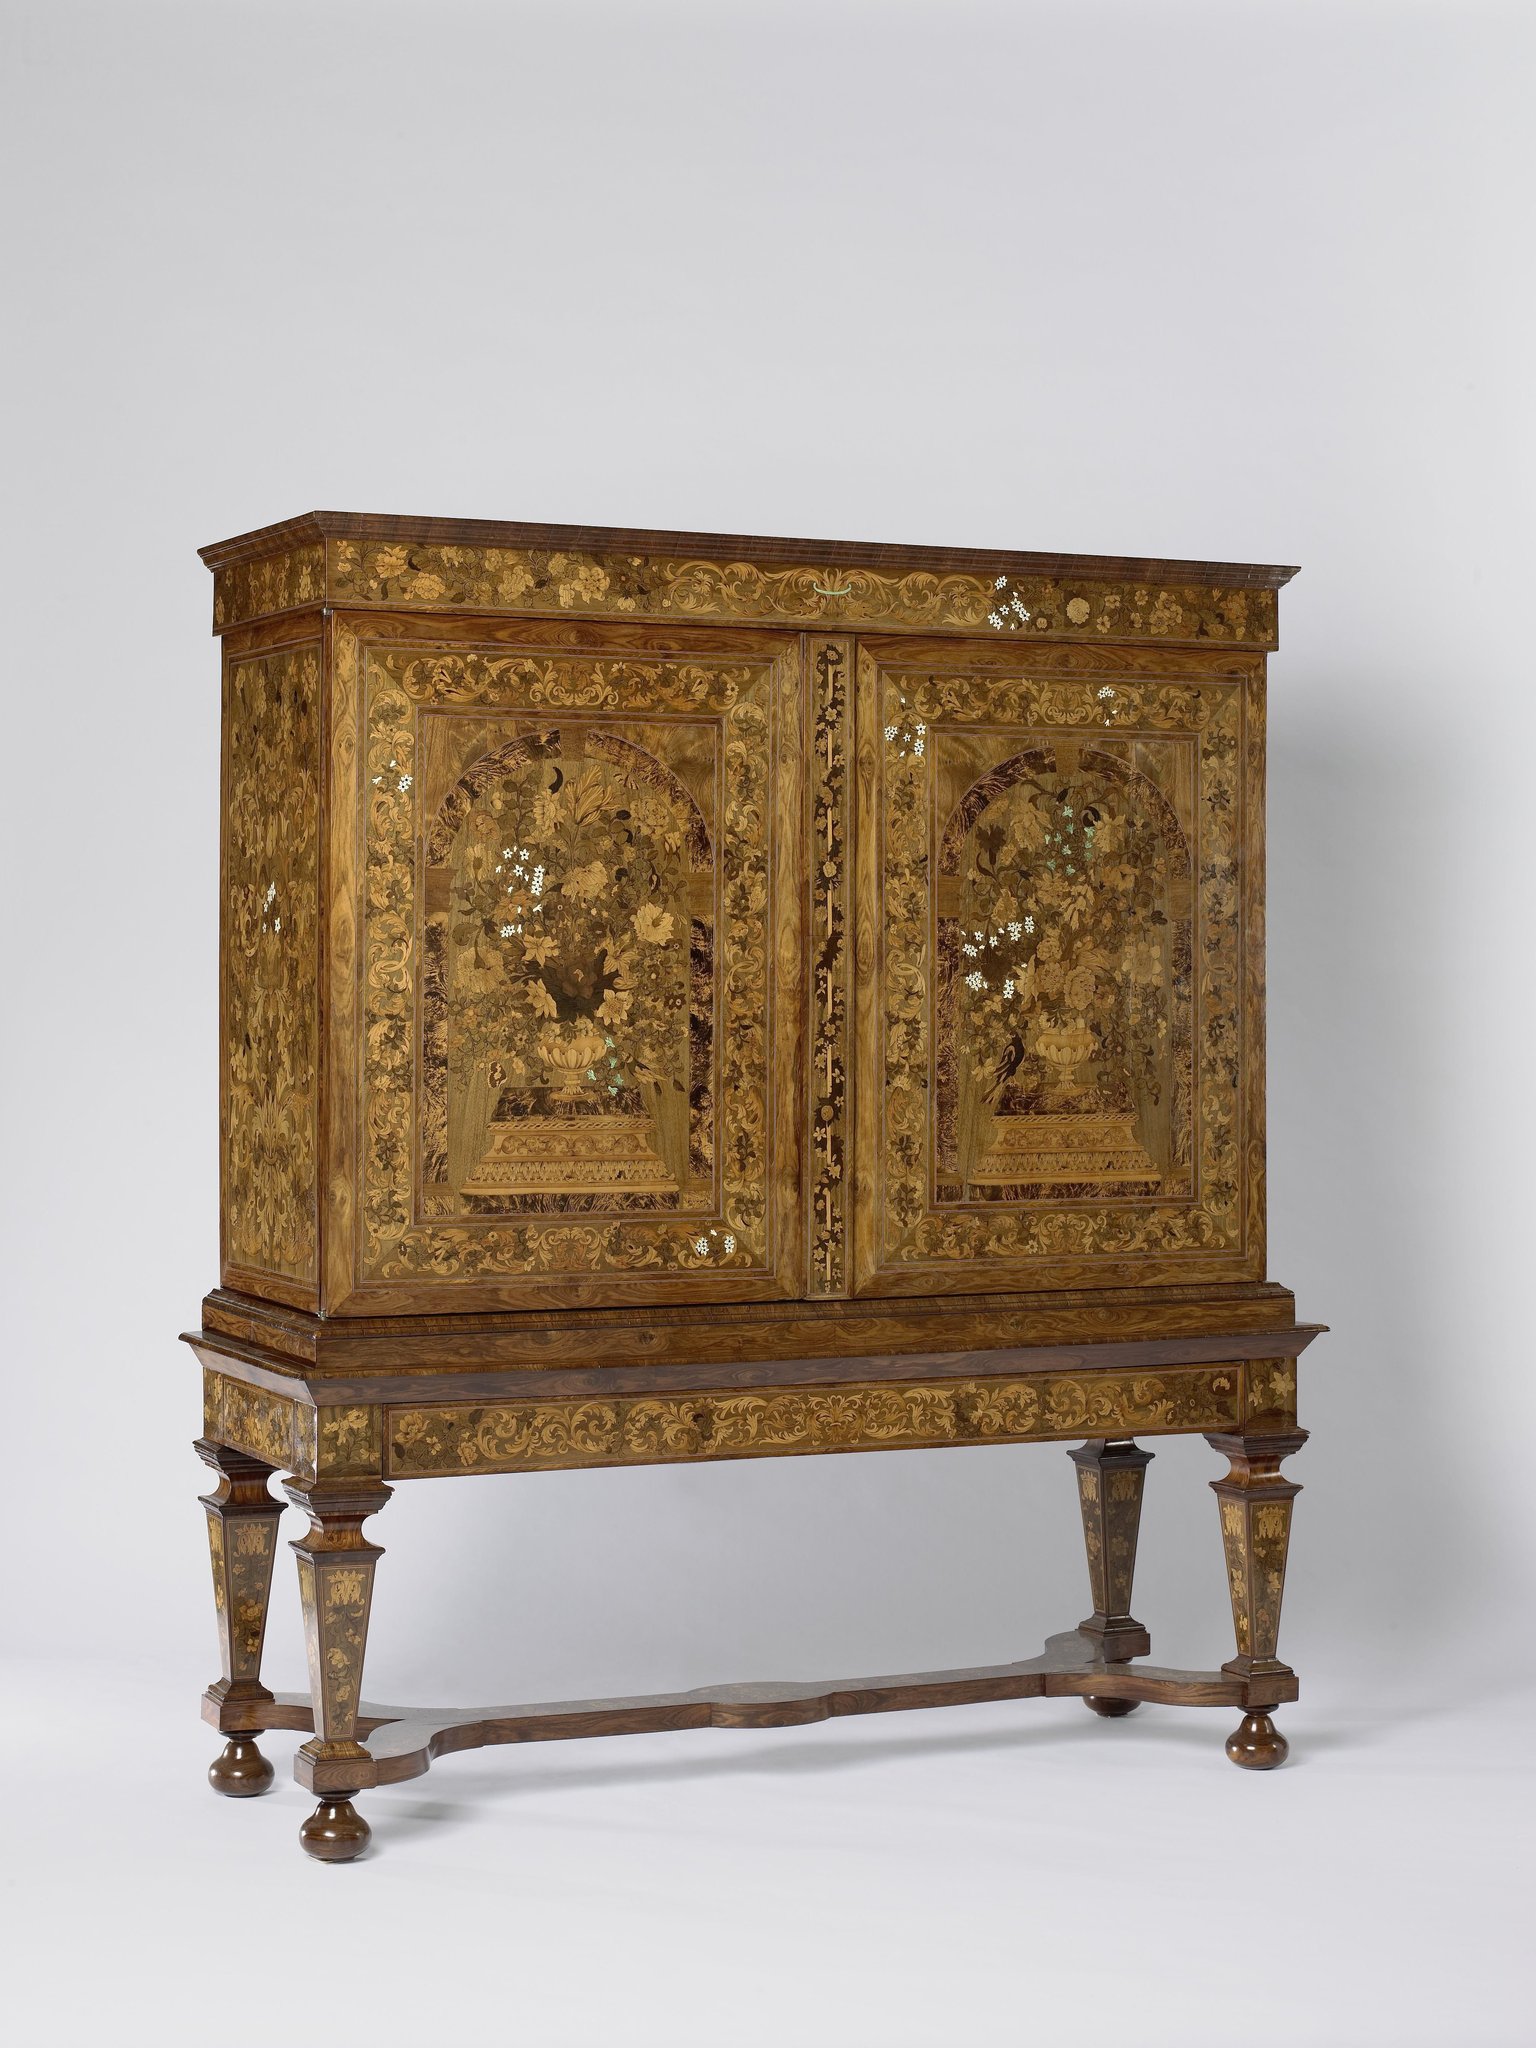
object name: furniture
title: Cabinet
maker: Anonymous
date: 1685-1700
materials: wood, bone, ivory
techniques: marquetry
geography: amsterdam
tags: flowers in a vase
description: The maker of this cabinet decorated it entirely with marquetry, some of which imitates stone. The flower vases, for example, seem to stand on a marble tabletop, which is actually made of little pieces of fancifully burled birch. Besides wood, bits of bone have been used to fashion the white and green flowers that enliven the cabinet.